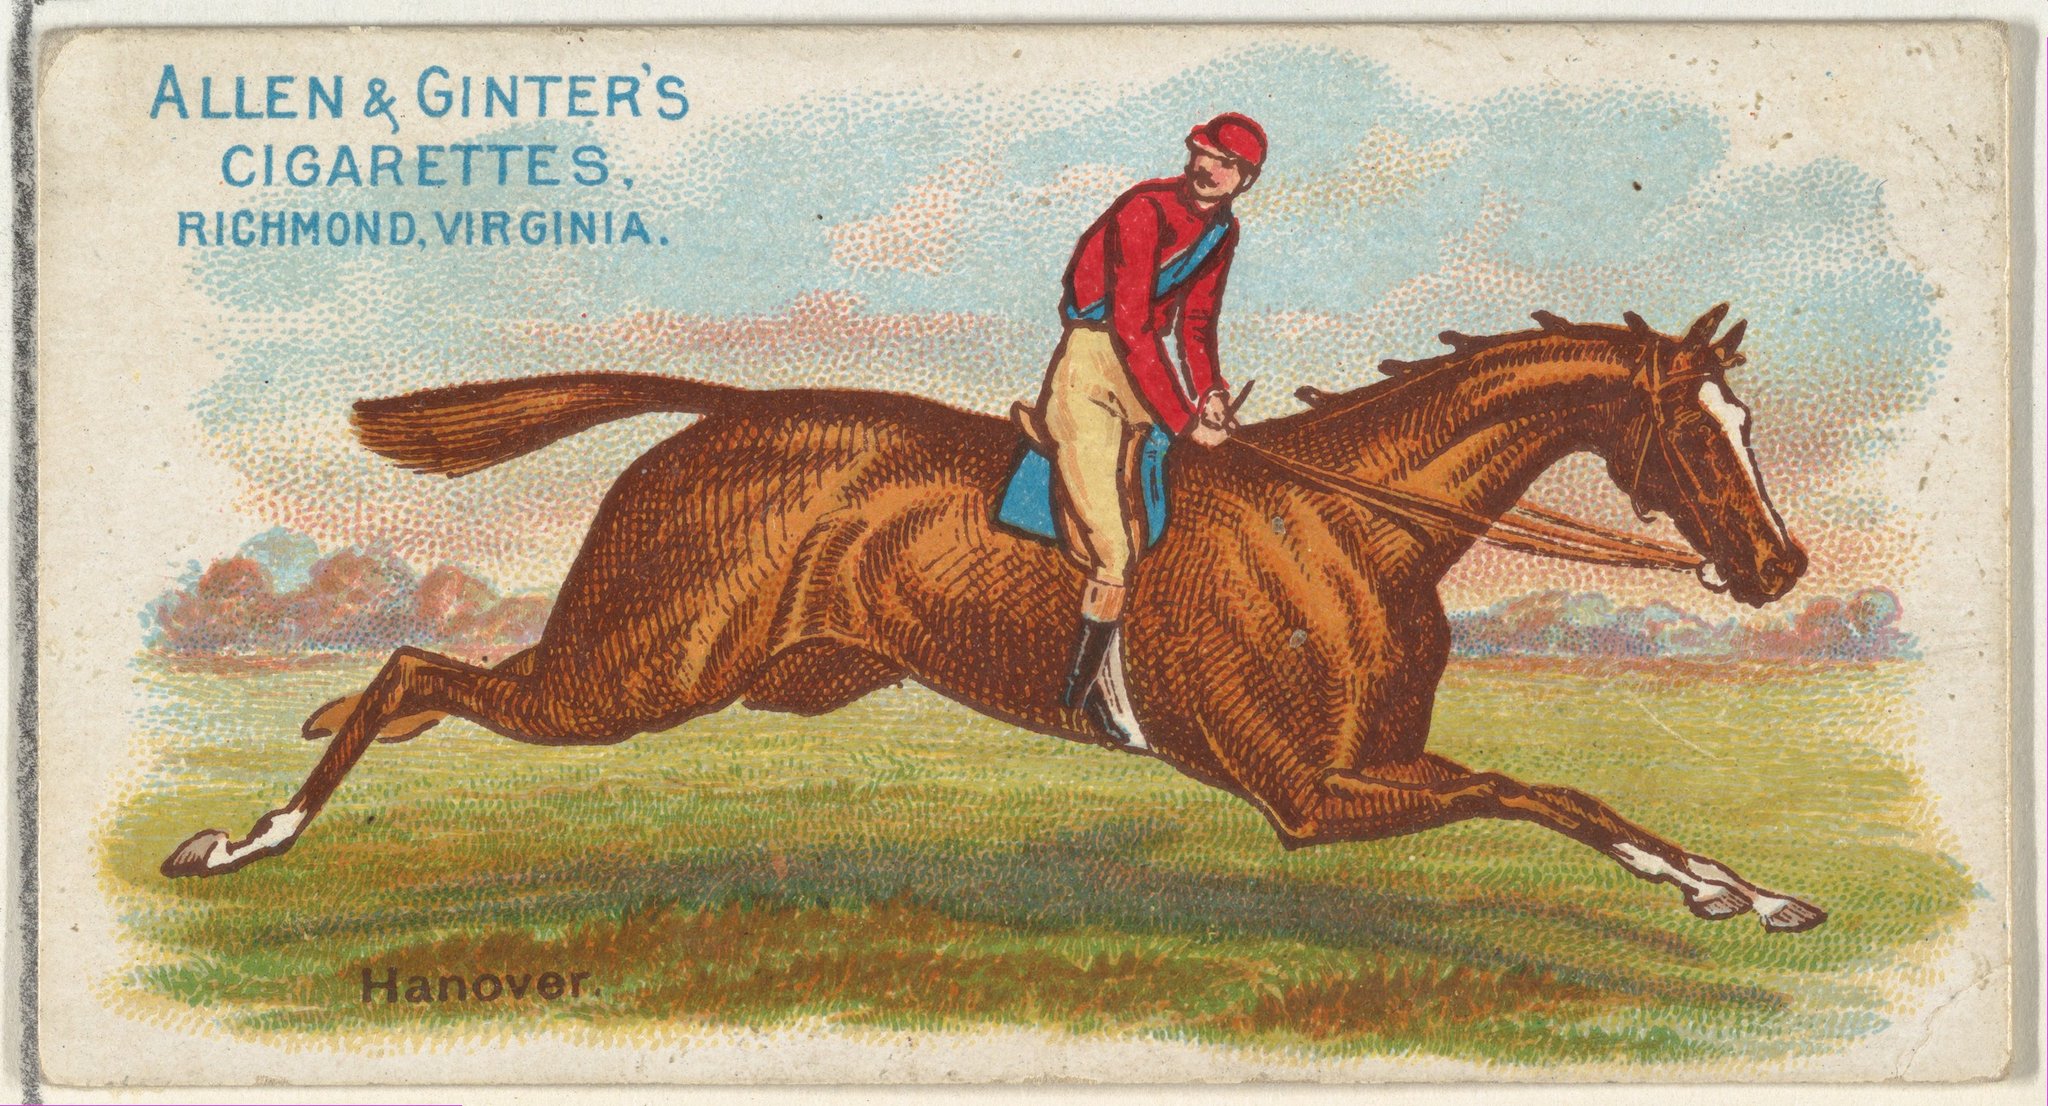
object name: print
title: Hanover, from The World's Racers series (N32) for Allen & Ginter Cigarettes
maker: allen & ginter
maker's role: publisher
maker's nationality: american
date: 1888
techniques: color lithograph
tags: men,horses,jockeys